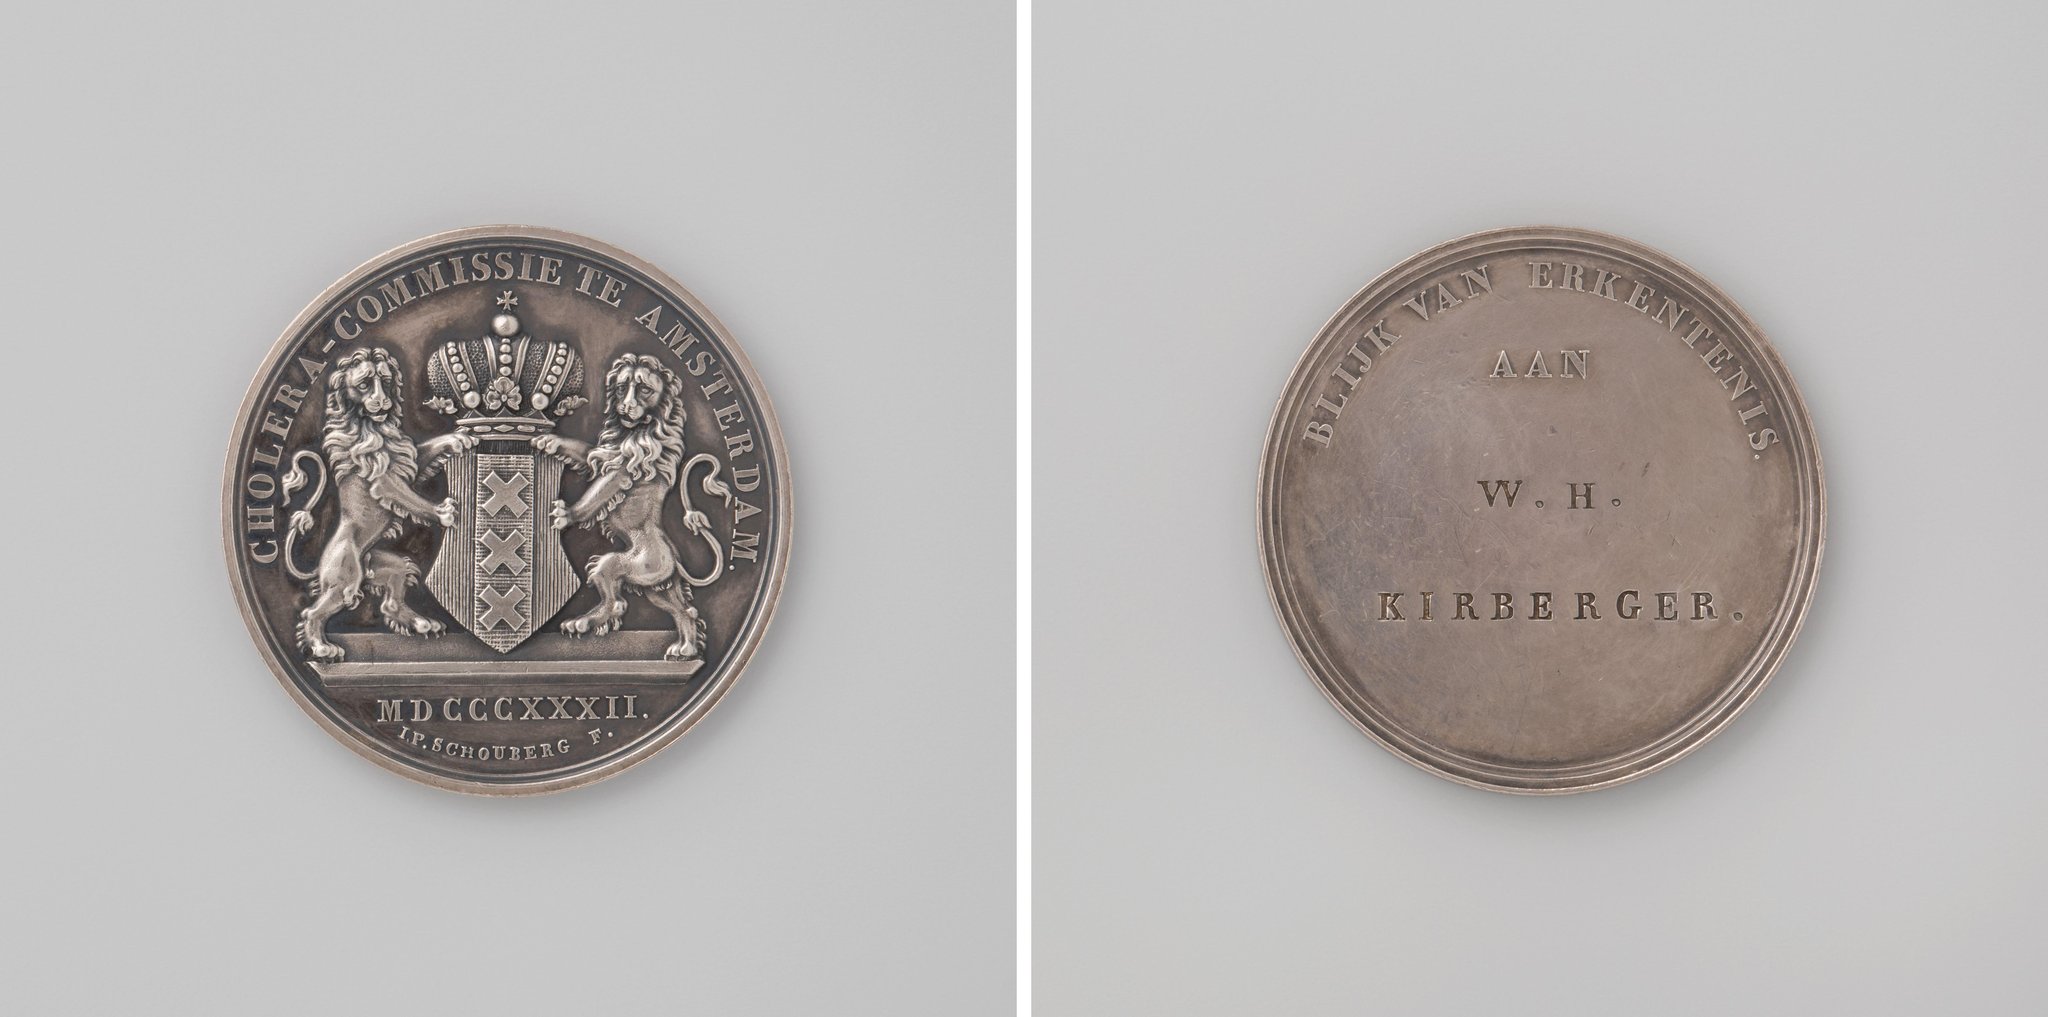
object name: honorary medal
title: Cholera-commissie te Amsterdam, ter ere van wijkmeester W.H. Kirberger,wegens bewezen diensten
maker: johannis petrus schouberg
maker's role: die cutter, draughtsman, print maker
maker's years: 1798-1864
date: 1832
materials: silver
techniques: engraving, striking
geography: utrecht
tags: amsterdam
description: Zilveren penning. Voorzijde: gekroond wapenschild, geflankeerd door twee leeuwen binnen omschrift;afsnede: opschrift. Keerzijde: opschrift binnen omschrift